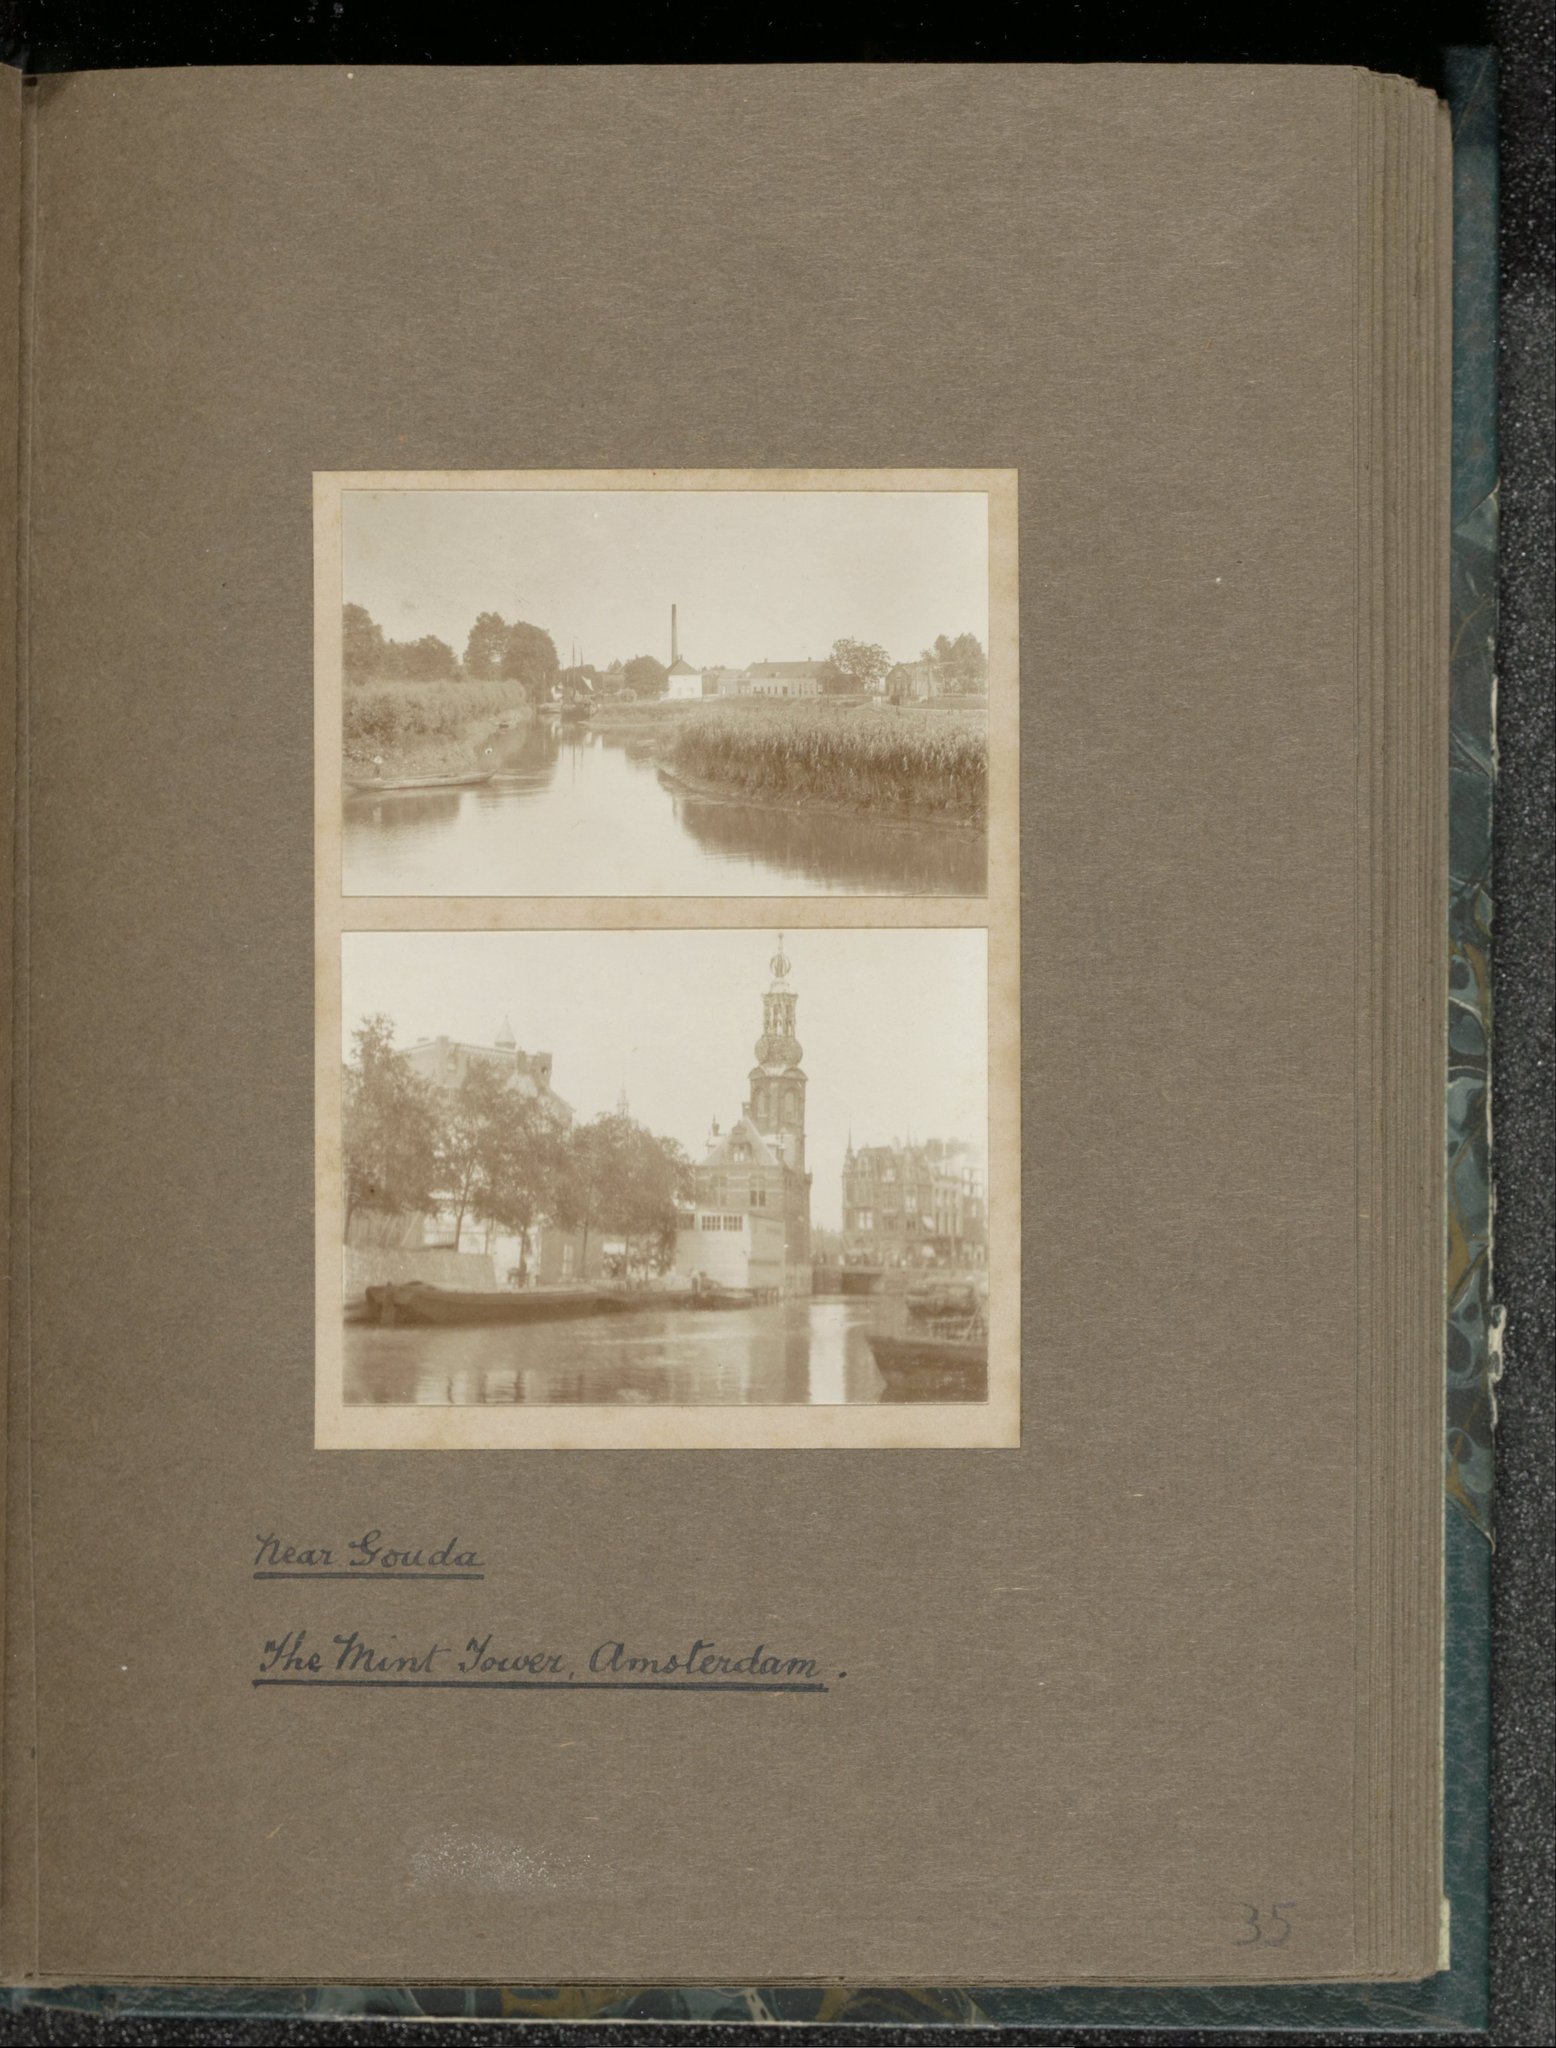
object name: photograph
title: Near Gouda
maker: Anonymous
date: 1912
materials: photographic support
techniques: gelatin silver print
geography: gouda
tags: smoke-stack, pumping installation, pumping-engine (~ polder) (+ variant), factory in landscape, plants and herbs: reed, travelling; tourism, gouda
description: Onderdeel van Fotoalbum van de excursie naar Nederland van de Britse amateurfotografenvereniging P.C.U.K.